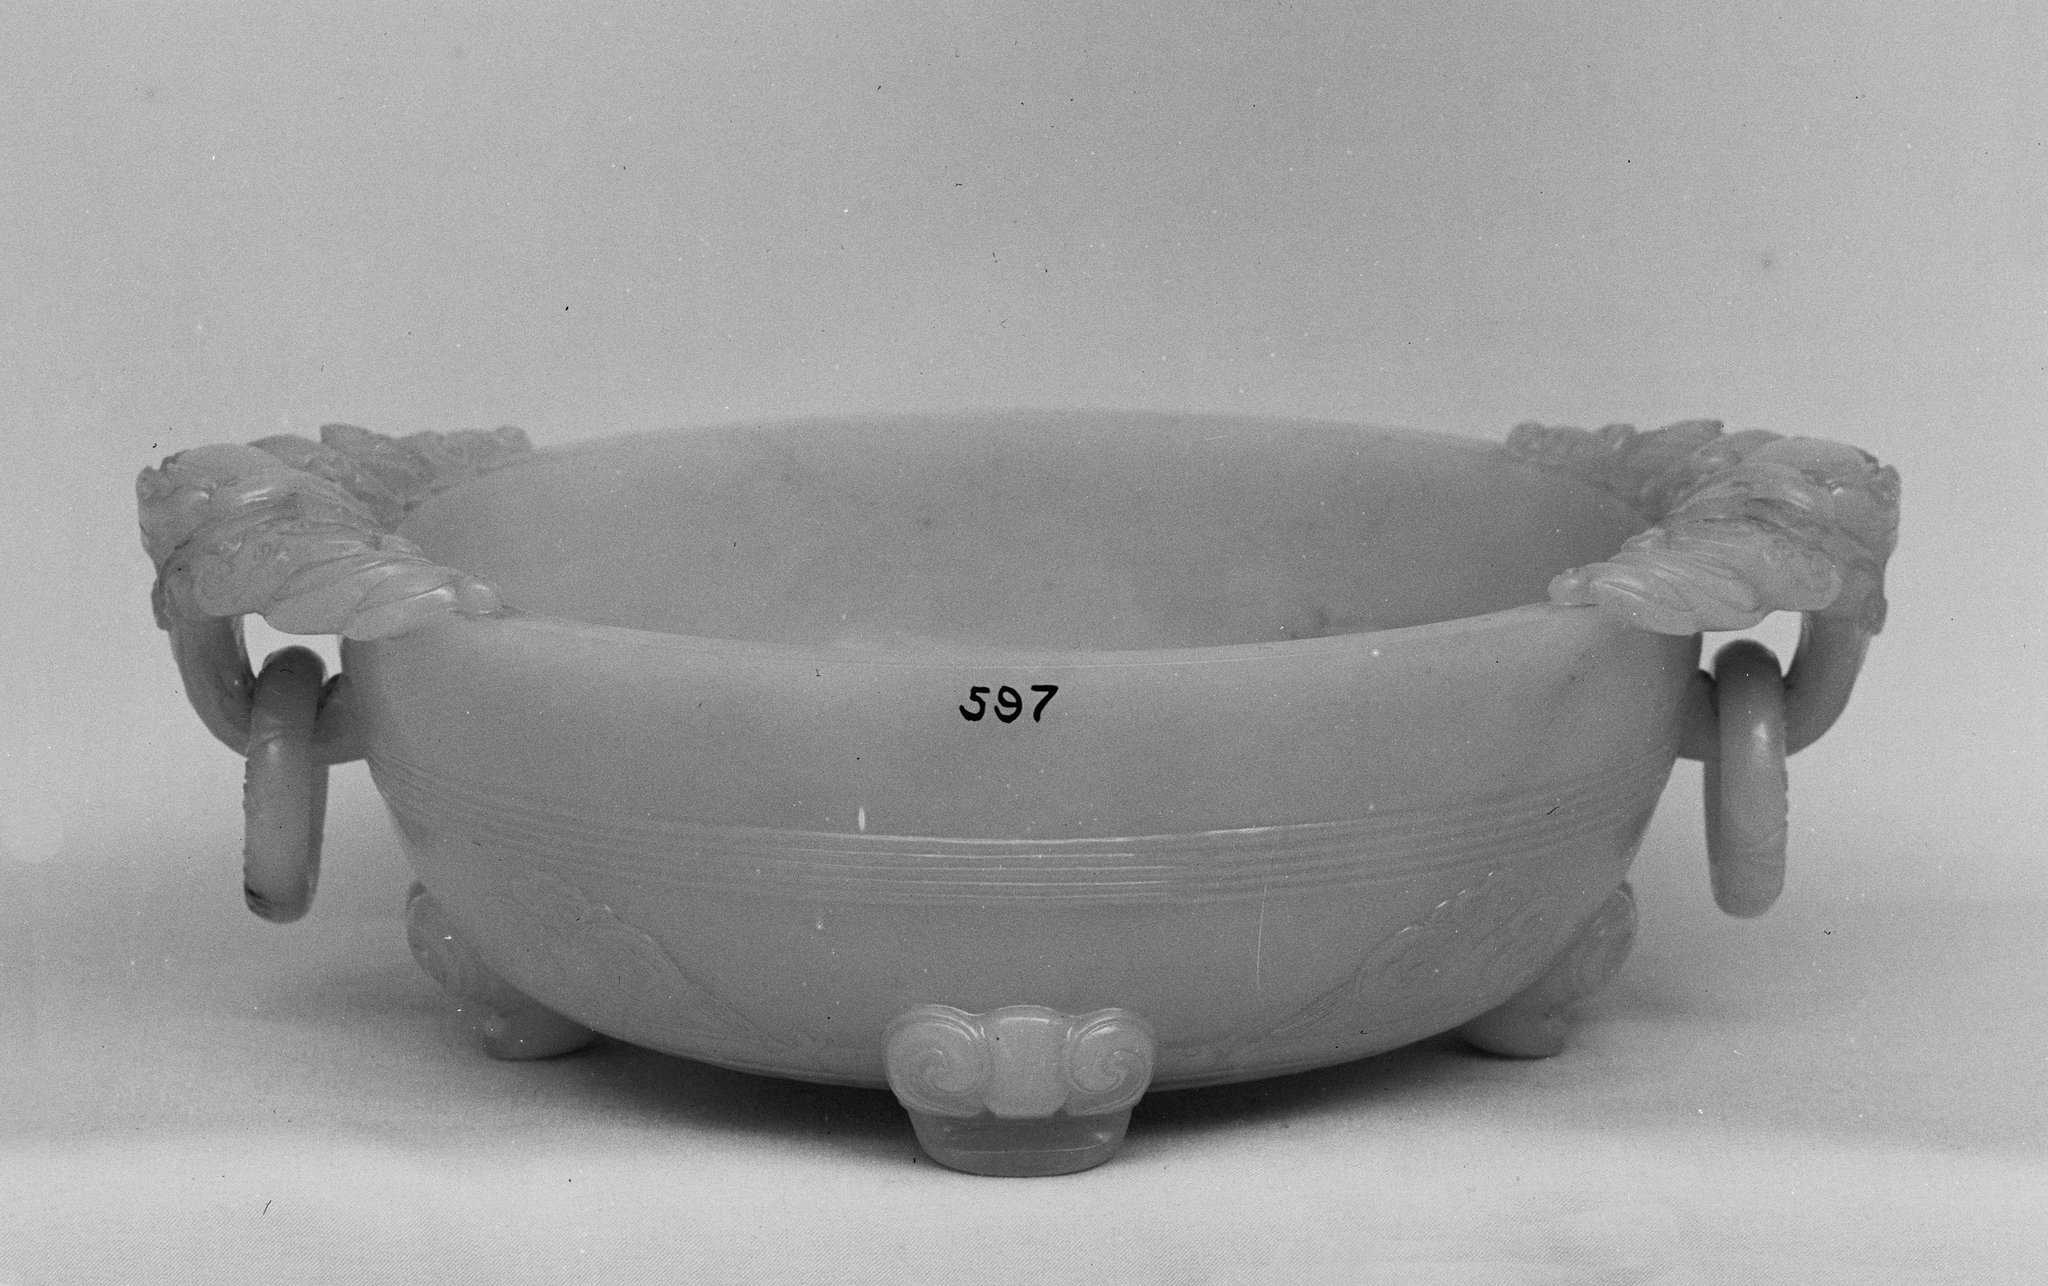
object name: bowl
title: Bowl with handles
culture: chinese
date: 1701-1800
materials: jade